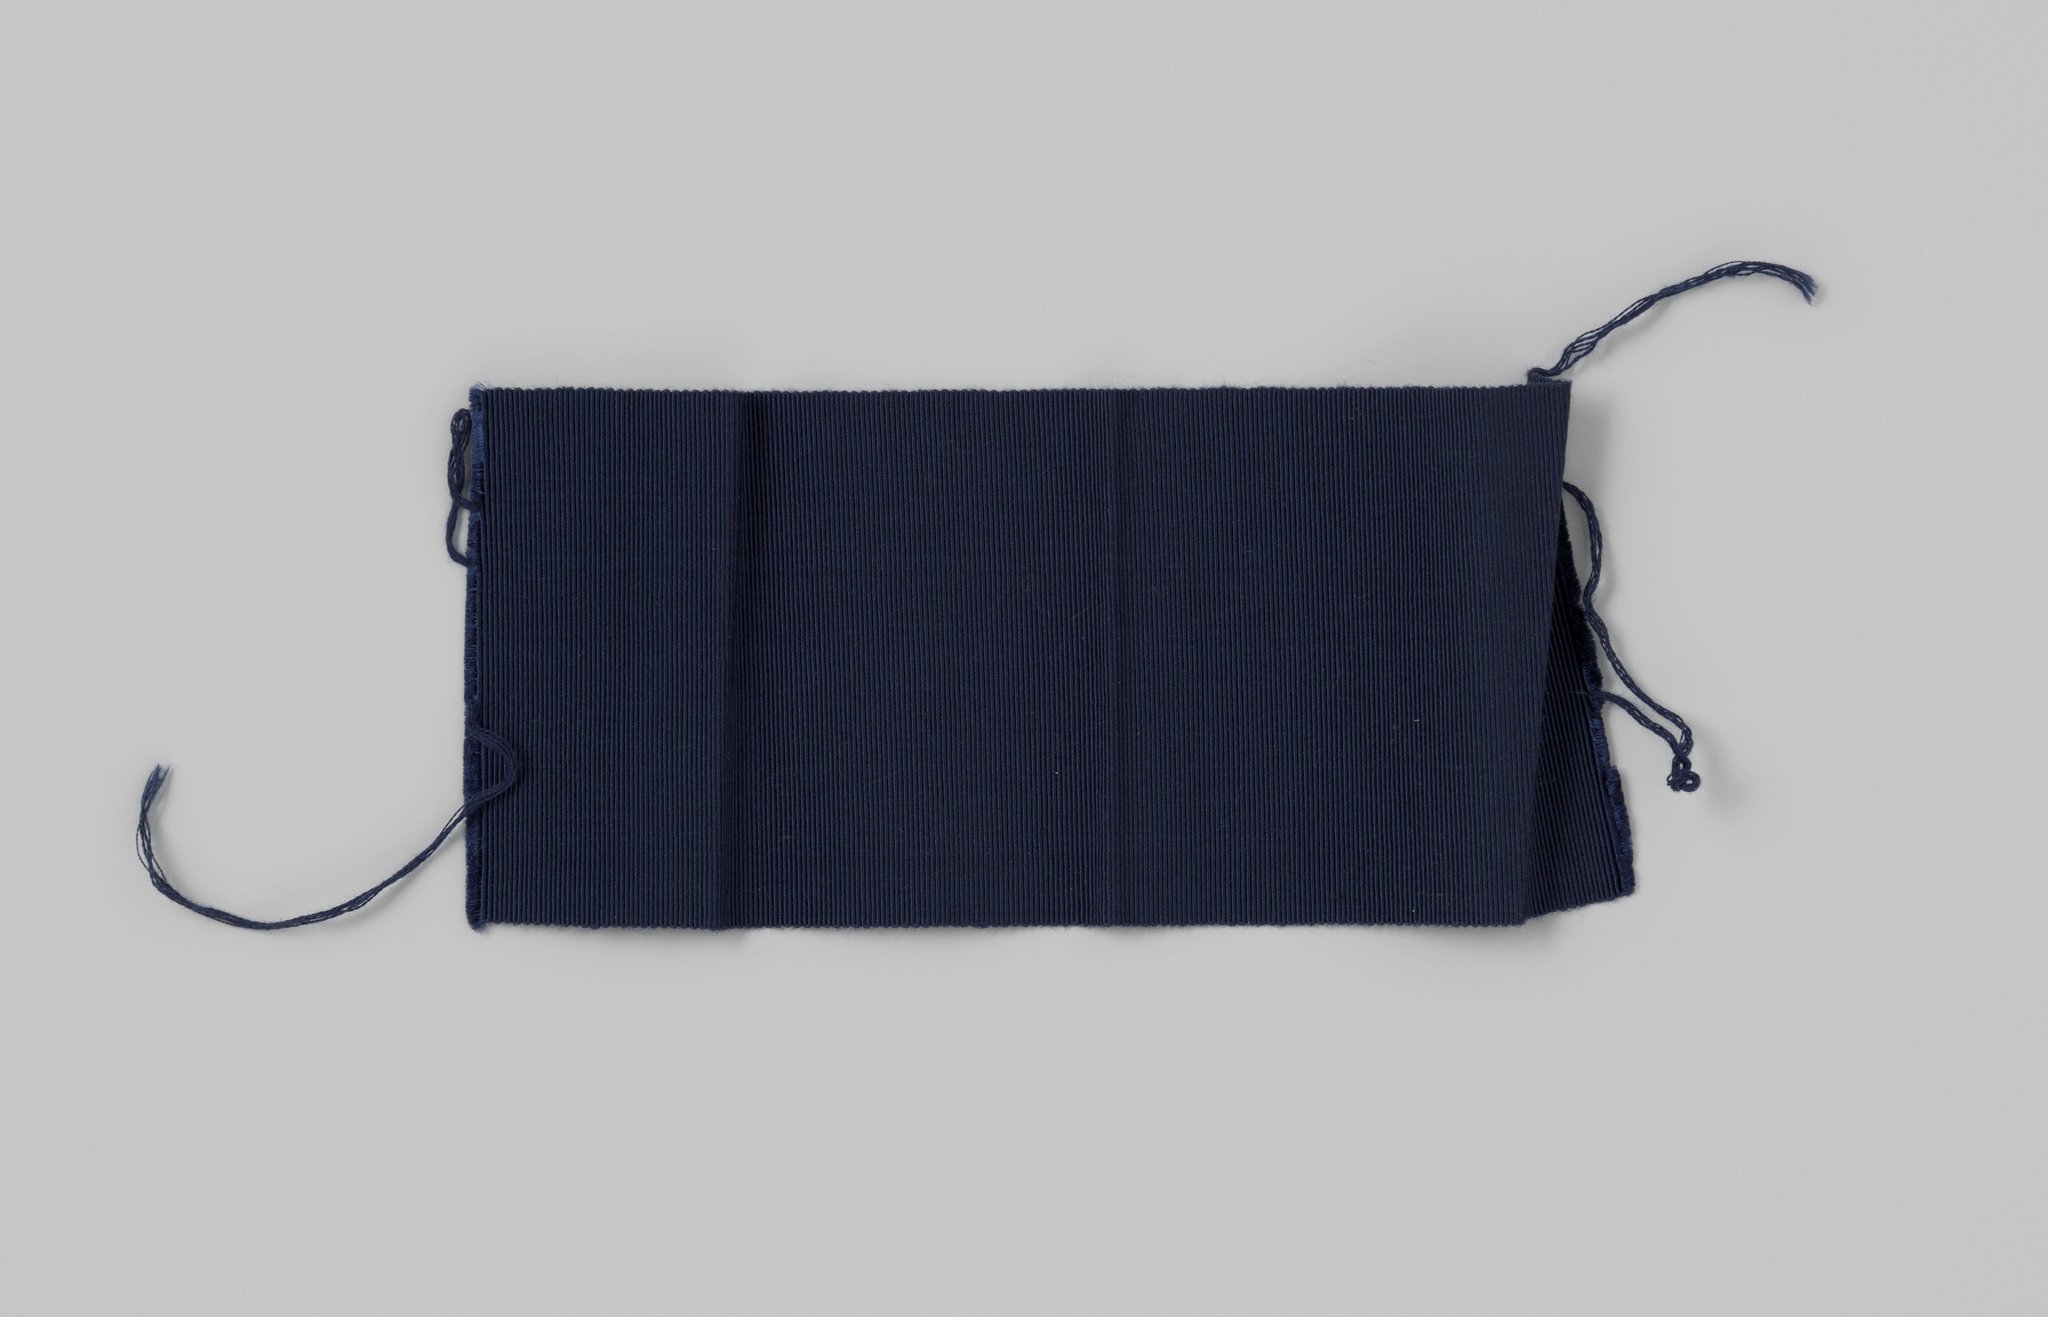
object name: ribbon material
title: Donkerblauw ripslint van katoen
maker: Anonymous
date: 1400-1950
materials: cotton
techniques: rib binding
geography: western europe